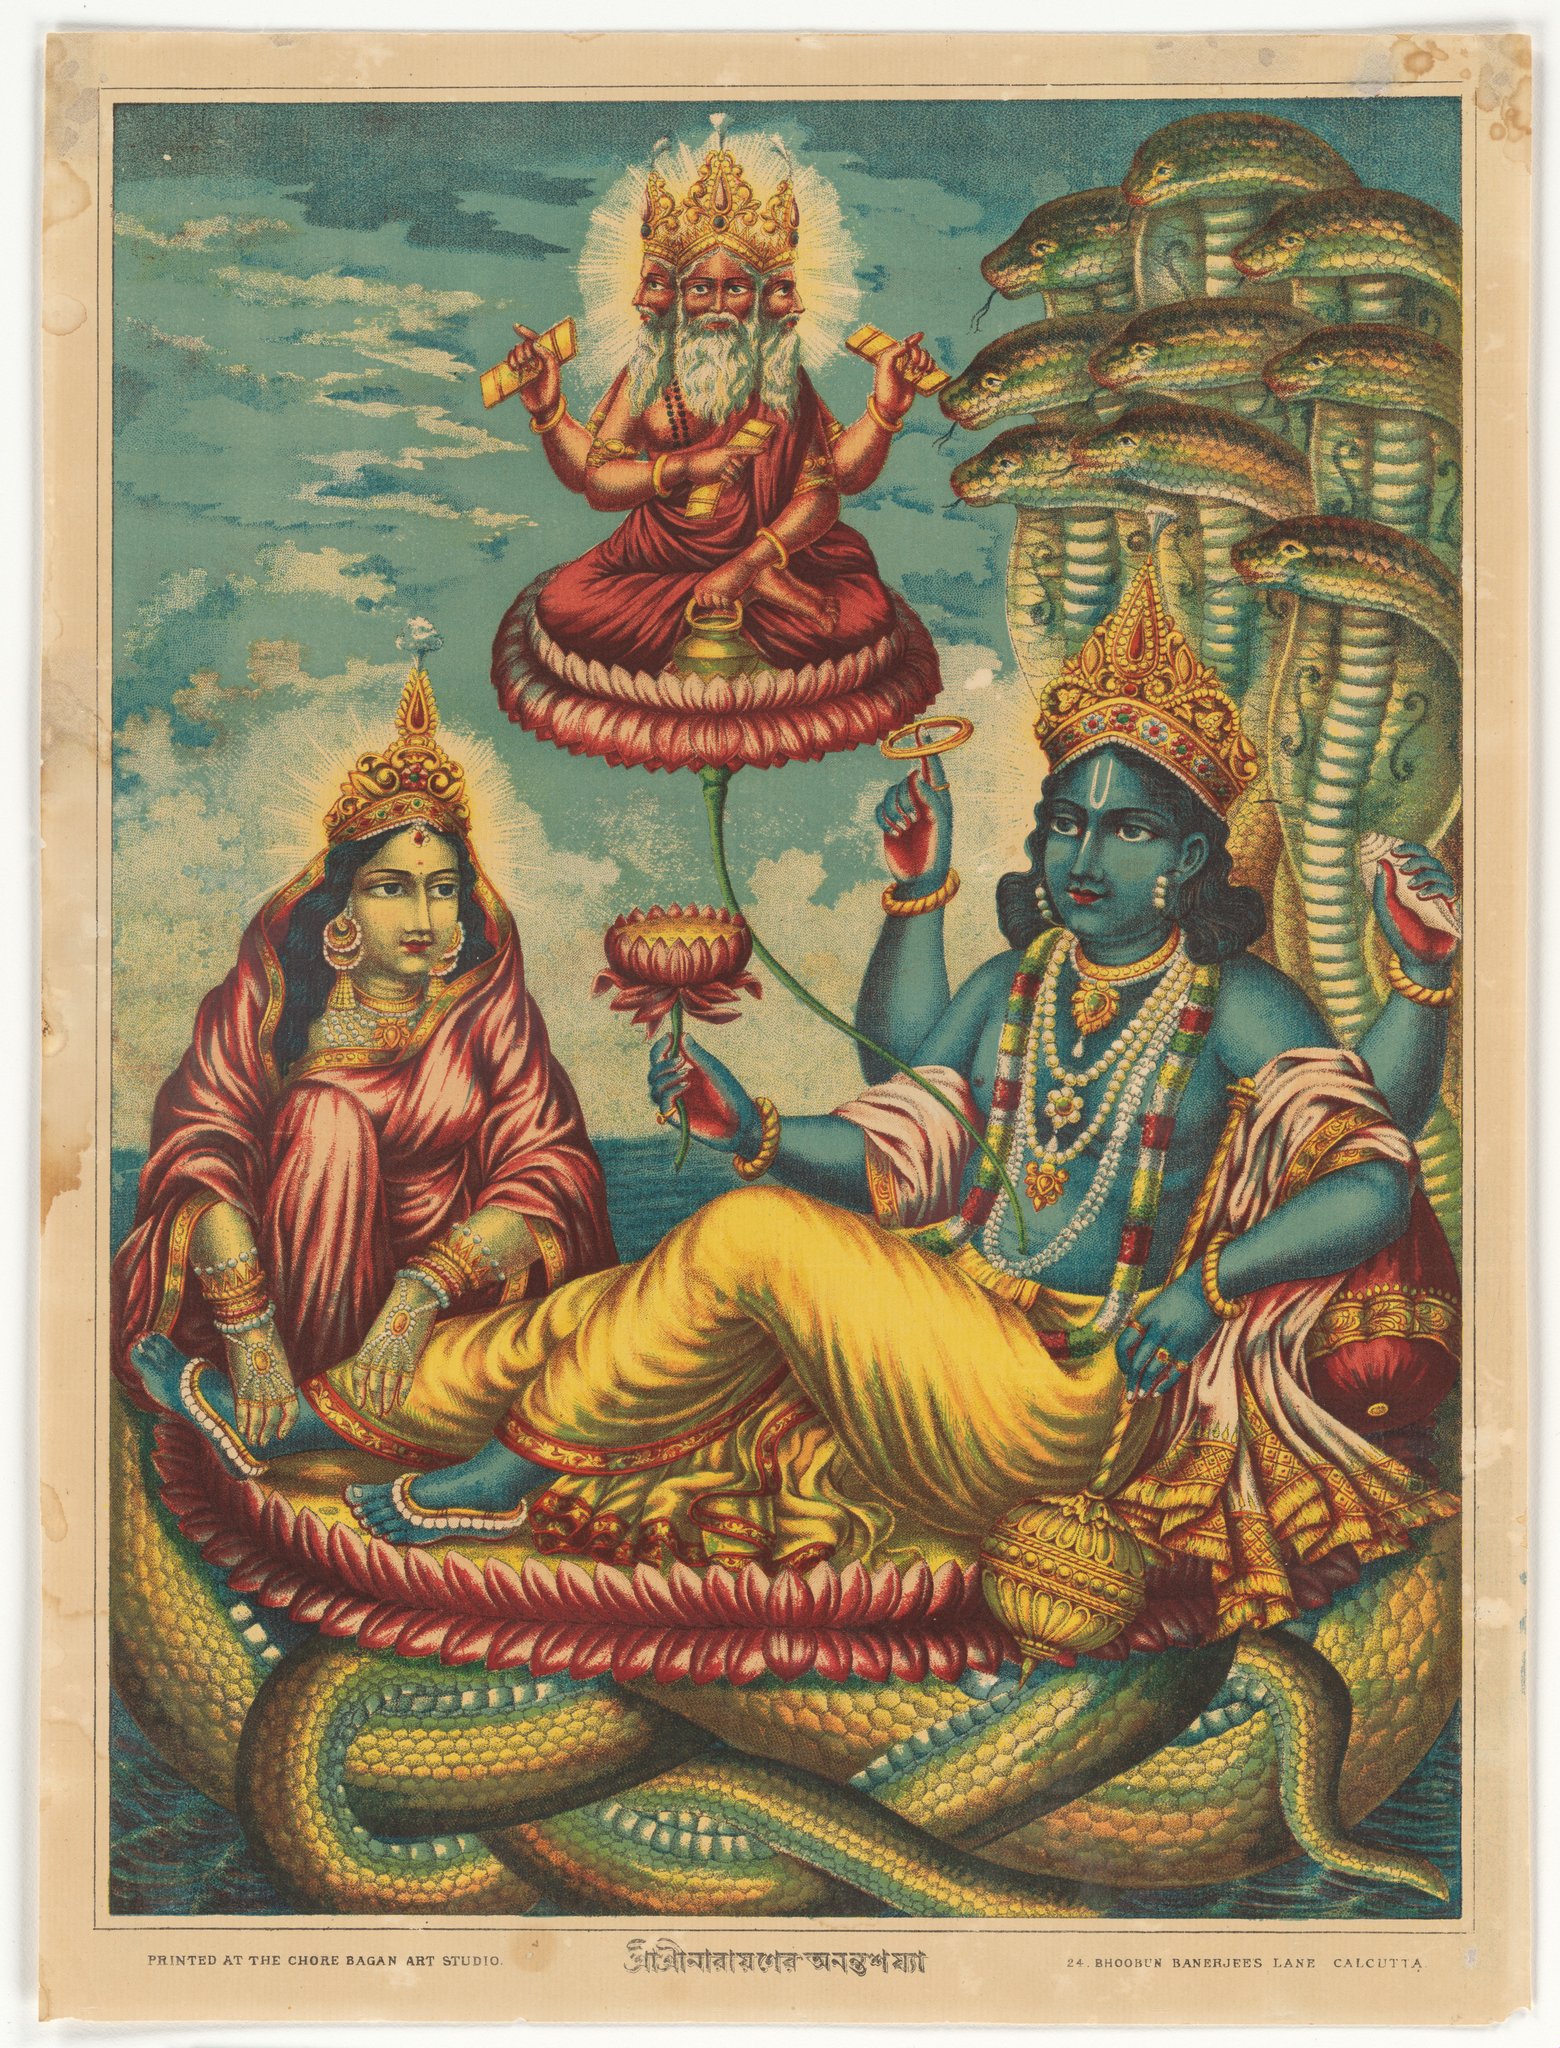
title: Shri Sheshanarayana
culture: west bengali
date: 1880-1885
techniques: lithograph